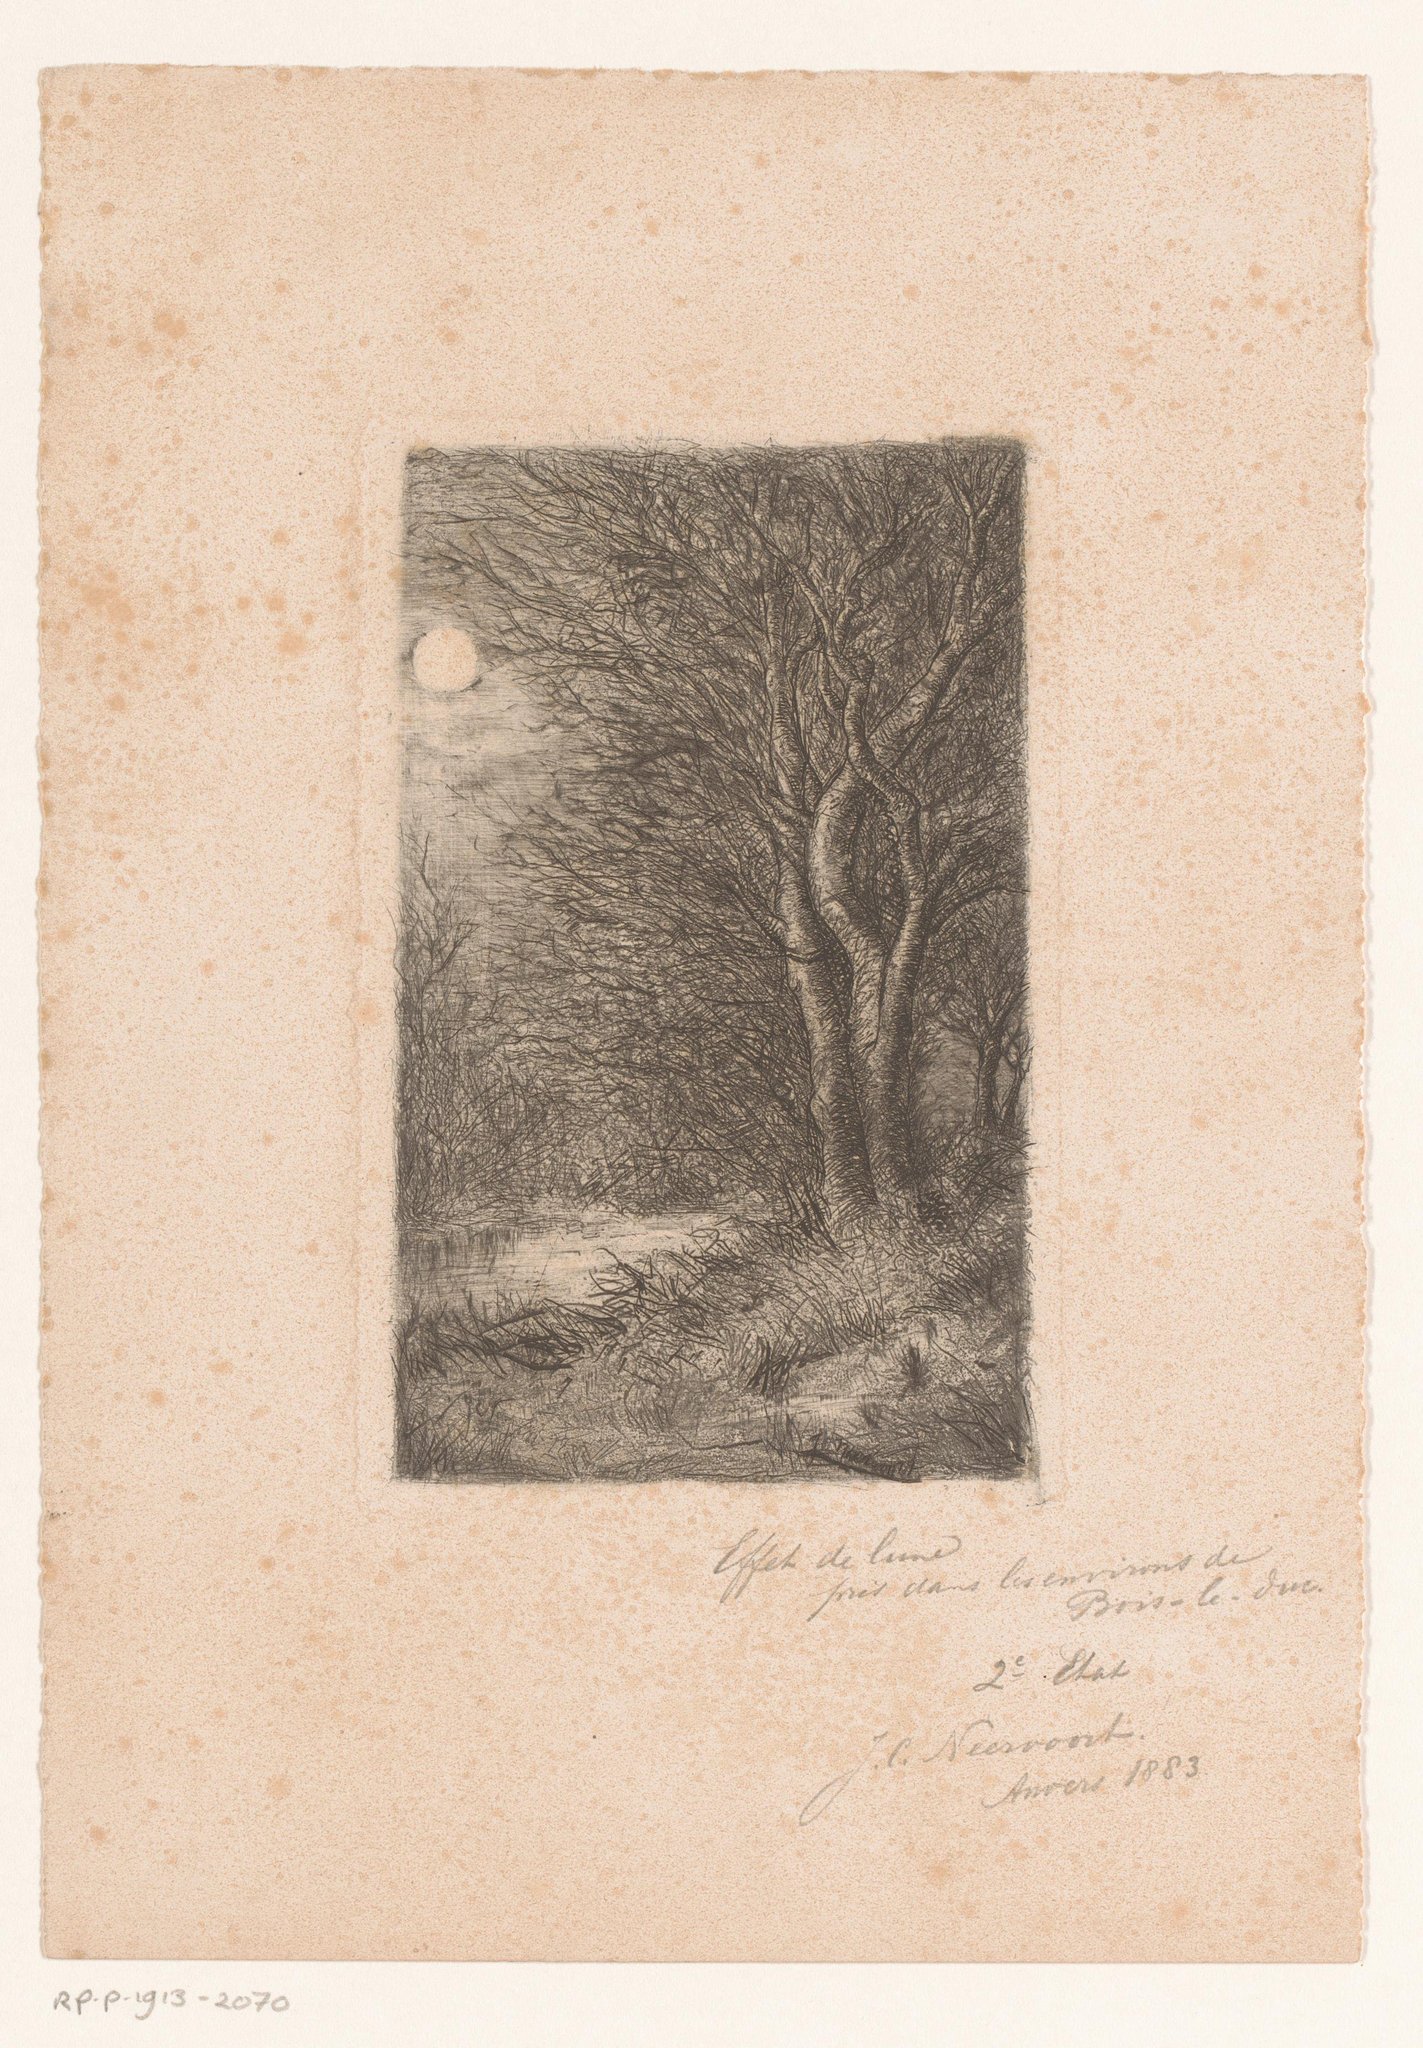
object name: print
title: Maanlandschap bij 's Hertogenbosch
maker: johannes cornelius neervoort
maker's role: print maker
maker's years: 1863-1940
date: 1883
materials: paper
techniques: drypoint, etching, intaglio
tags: full moon, landscapes with waters, waterscapes, seascapes (in the temperate zone), forest, wood, den bosch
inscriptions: inscription: ‘Effet de lune près dans les environs de Bois-le-duc, 2e Etat; Anvers 1883’, collector's mark: Lugt 2228